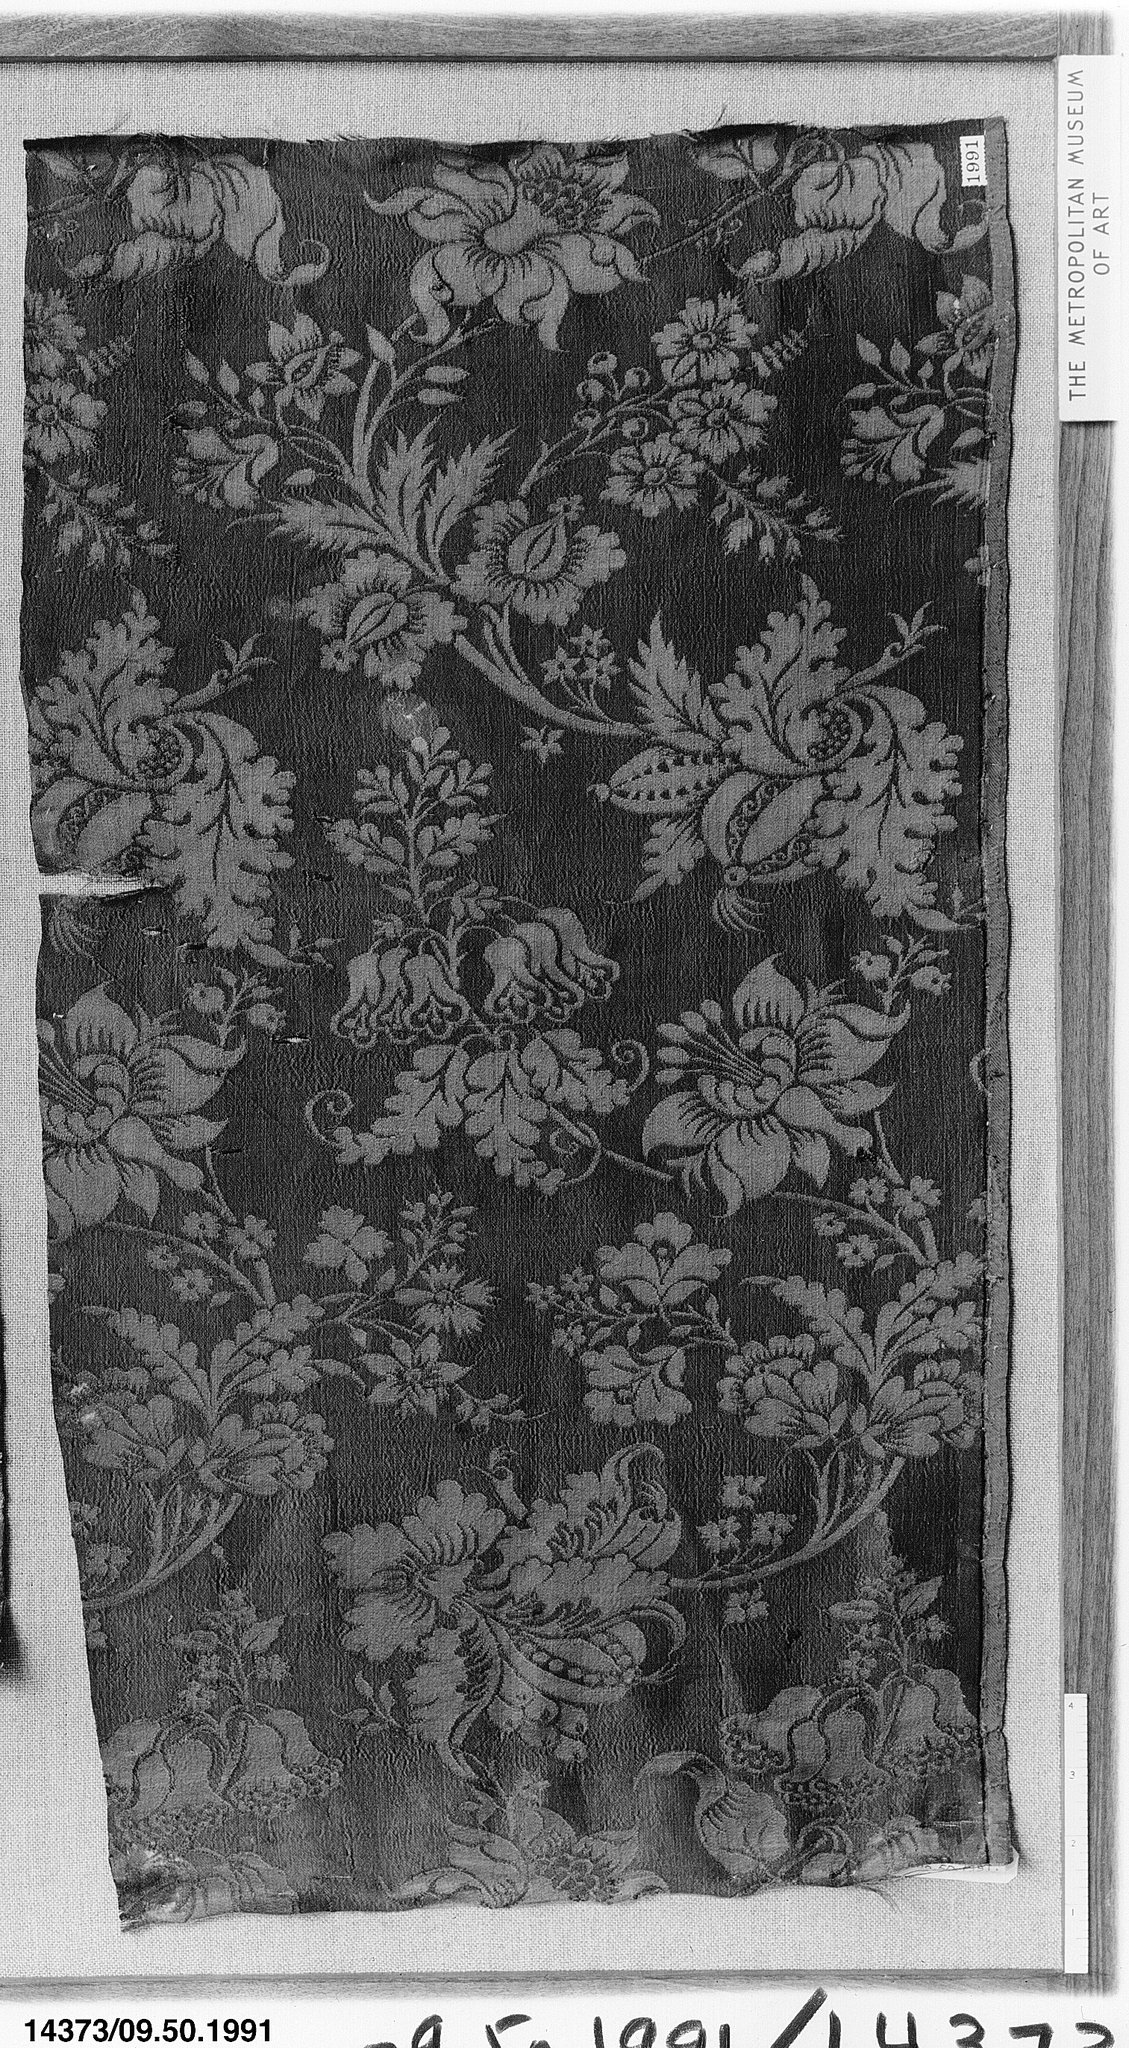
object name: piece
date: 1701-1733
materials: silk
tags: flowers,leaves